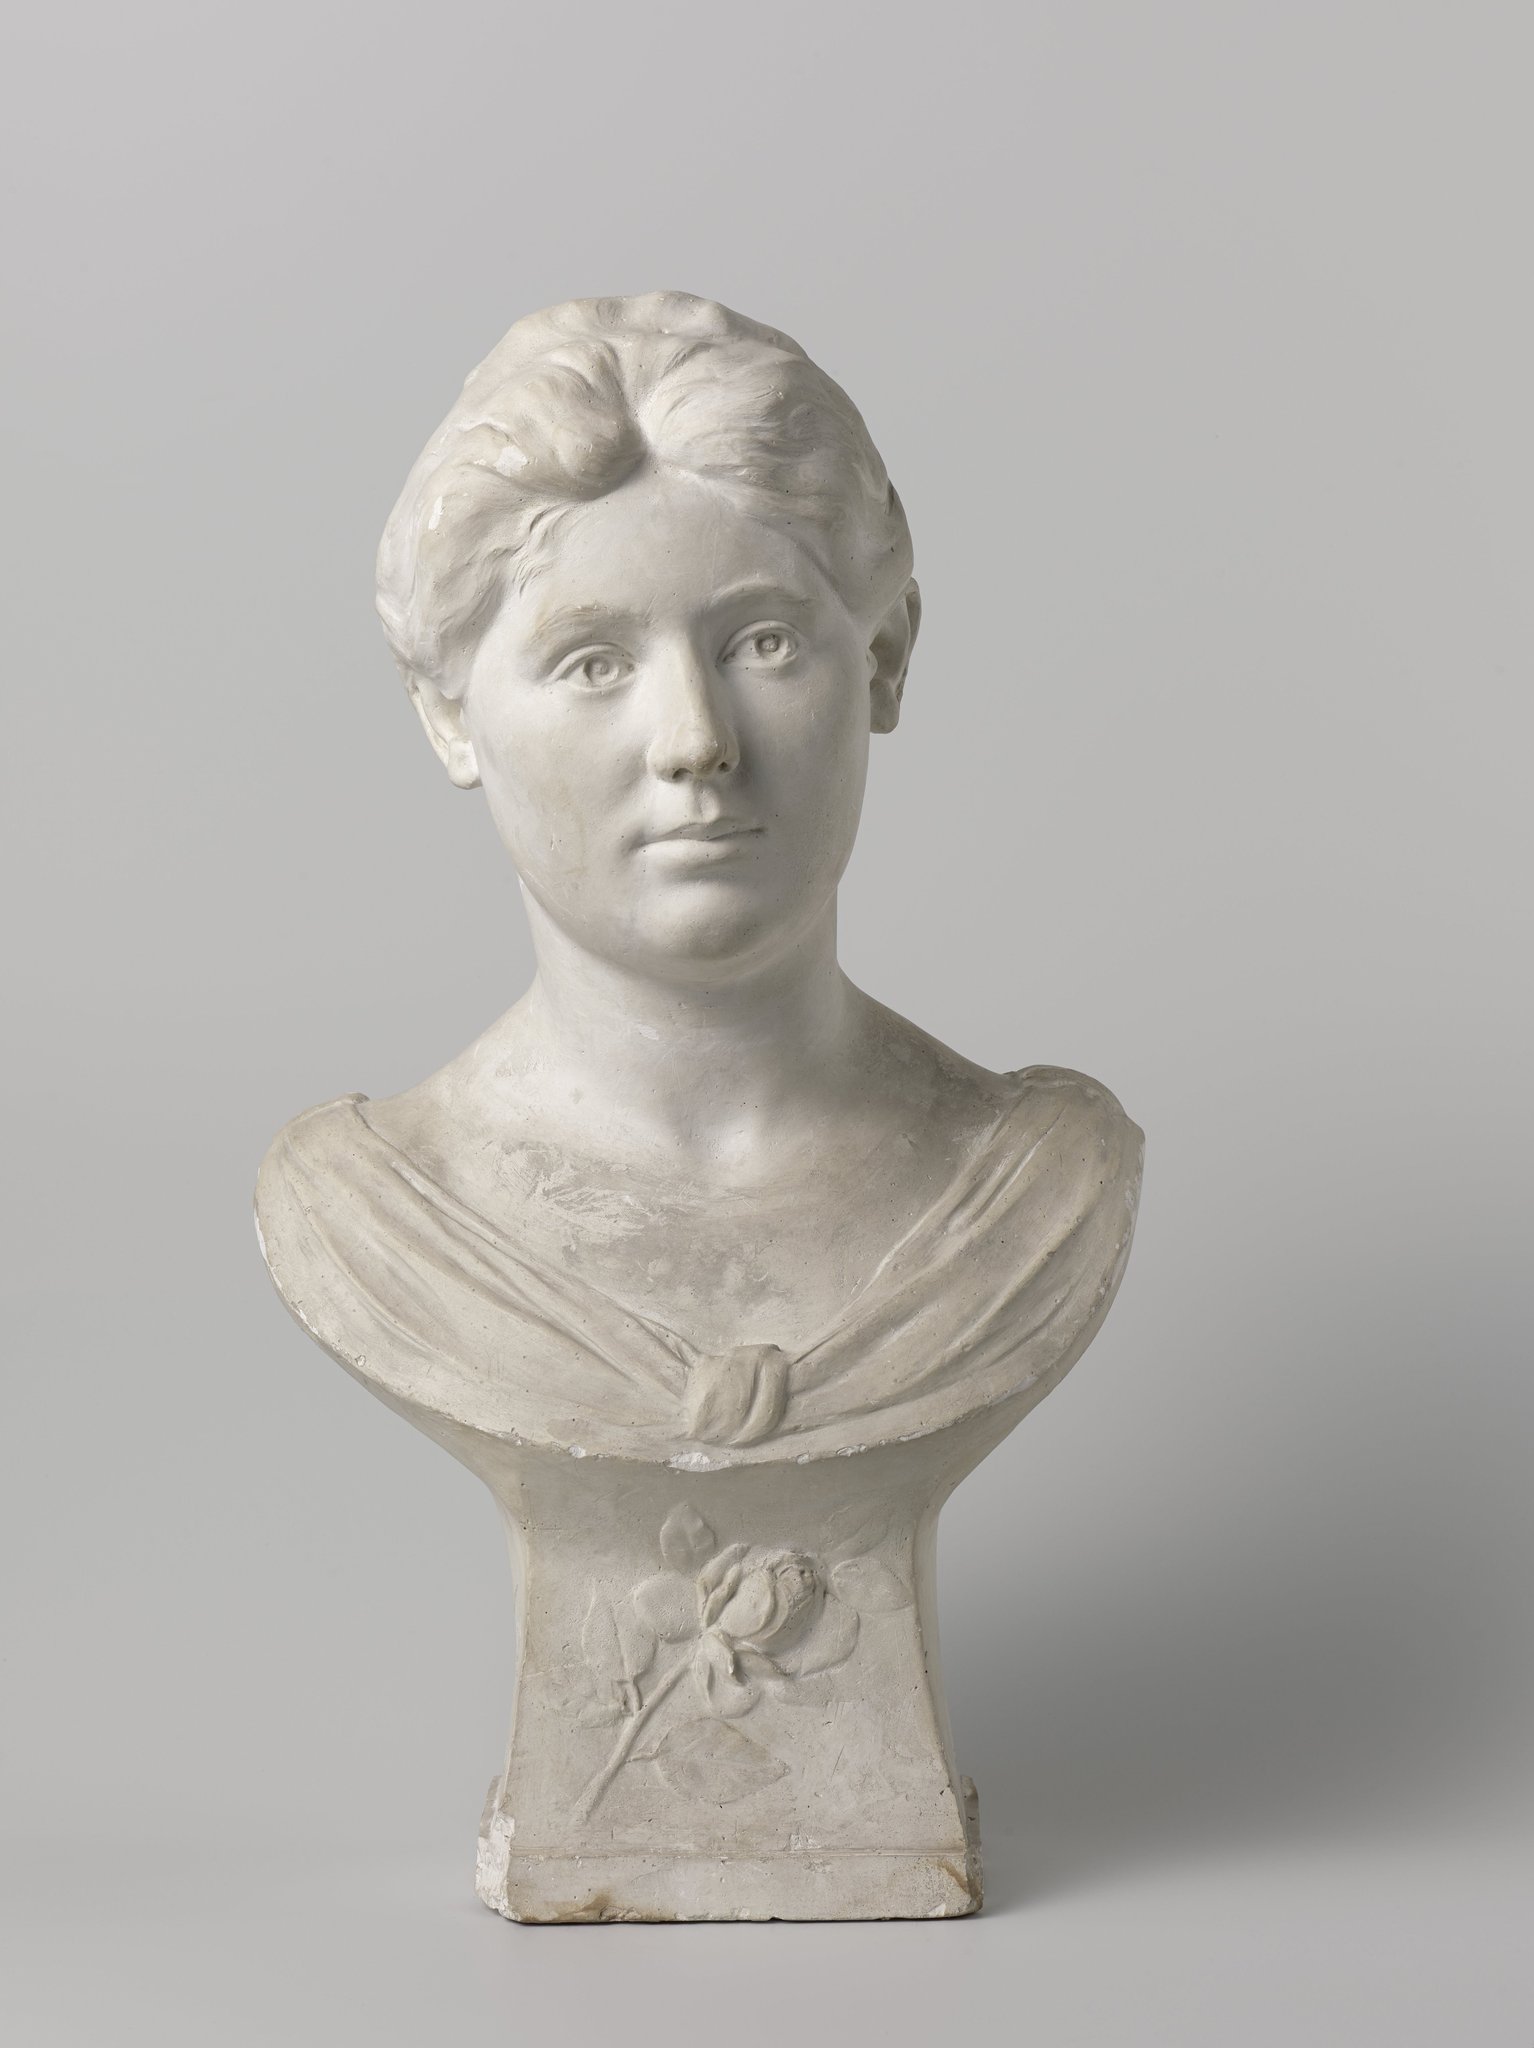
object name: sculpture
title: Portret-buste van Mevr. A. C. Berlage-van der Togt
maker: bart van hove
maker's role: sculptor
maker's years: 1850-1914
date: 1950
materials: gypsum